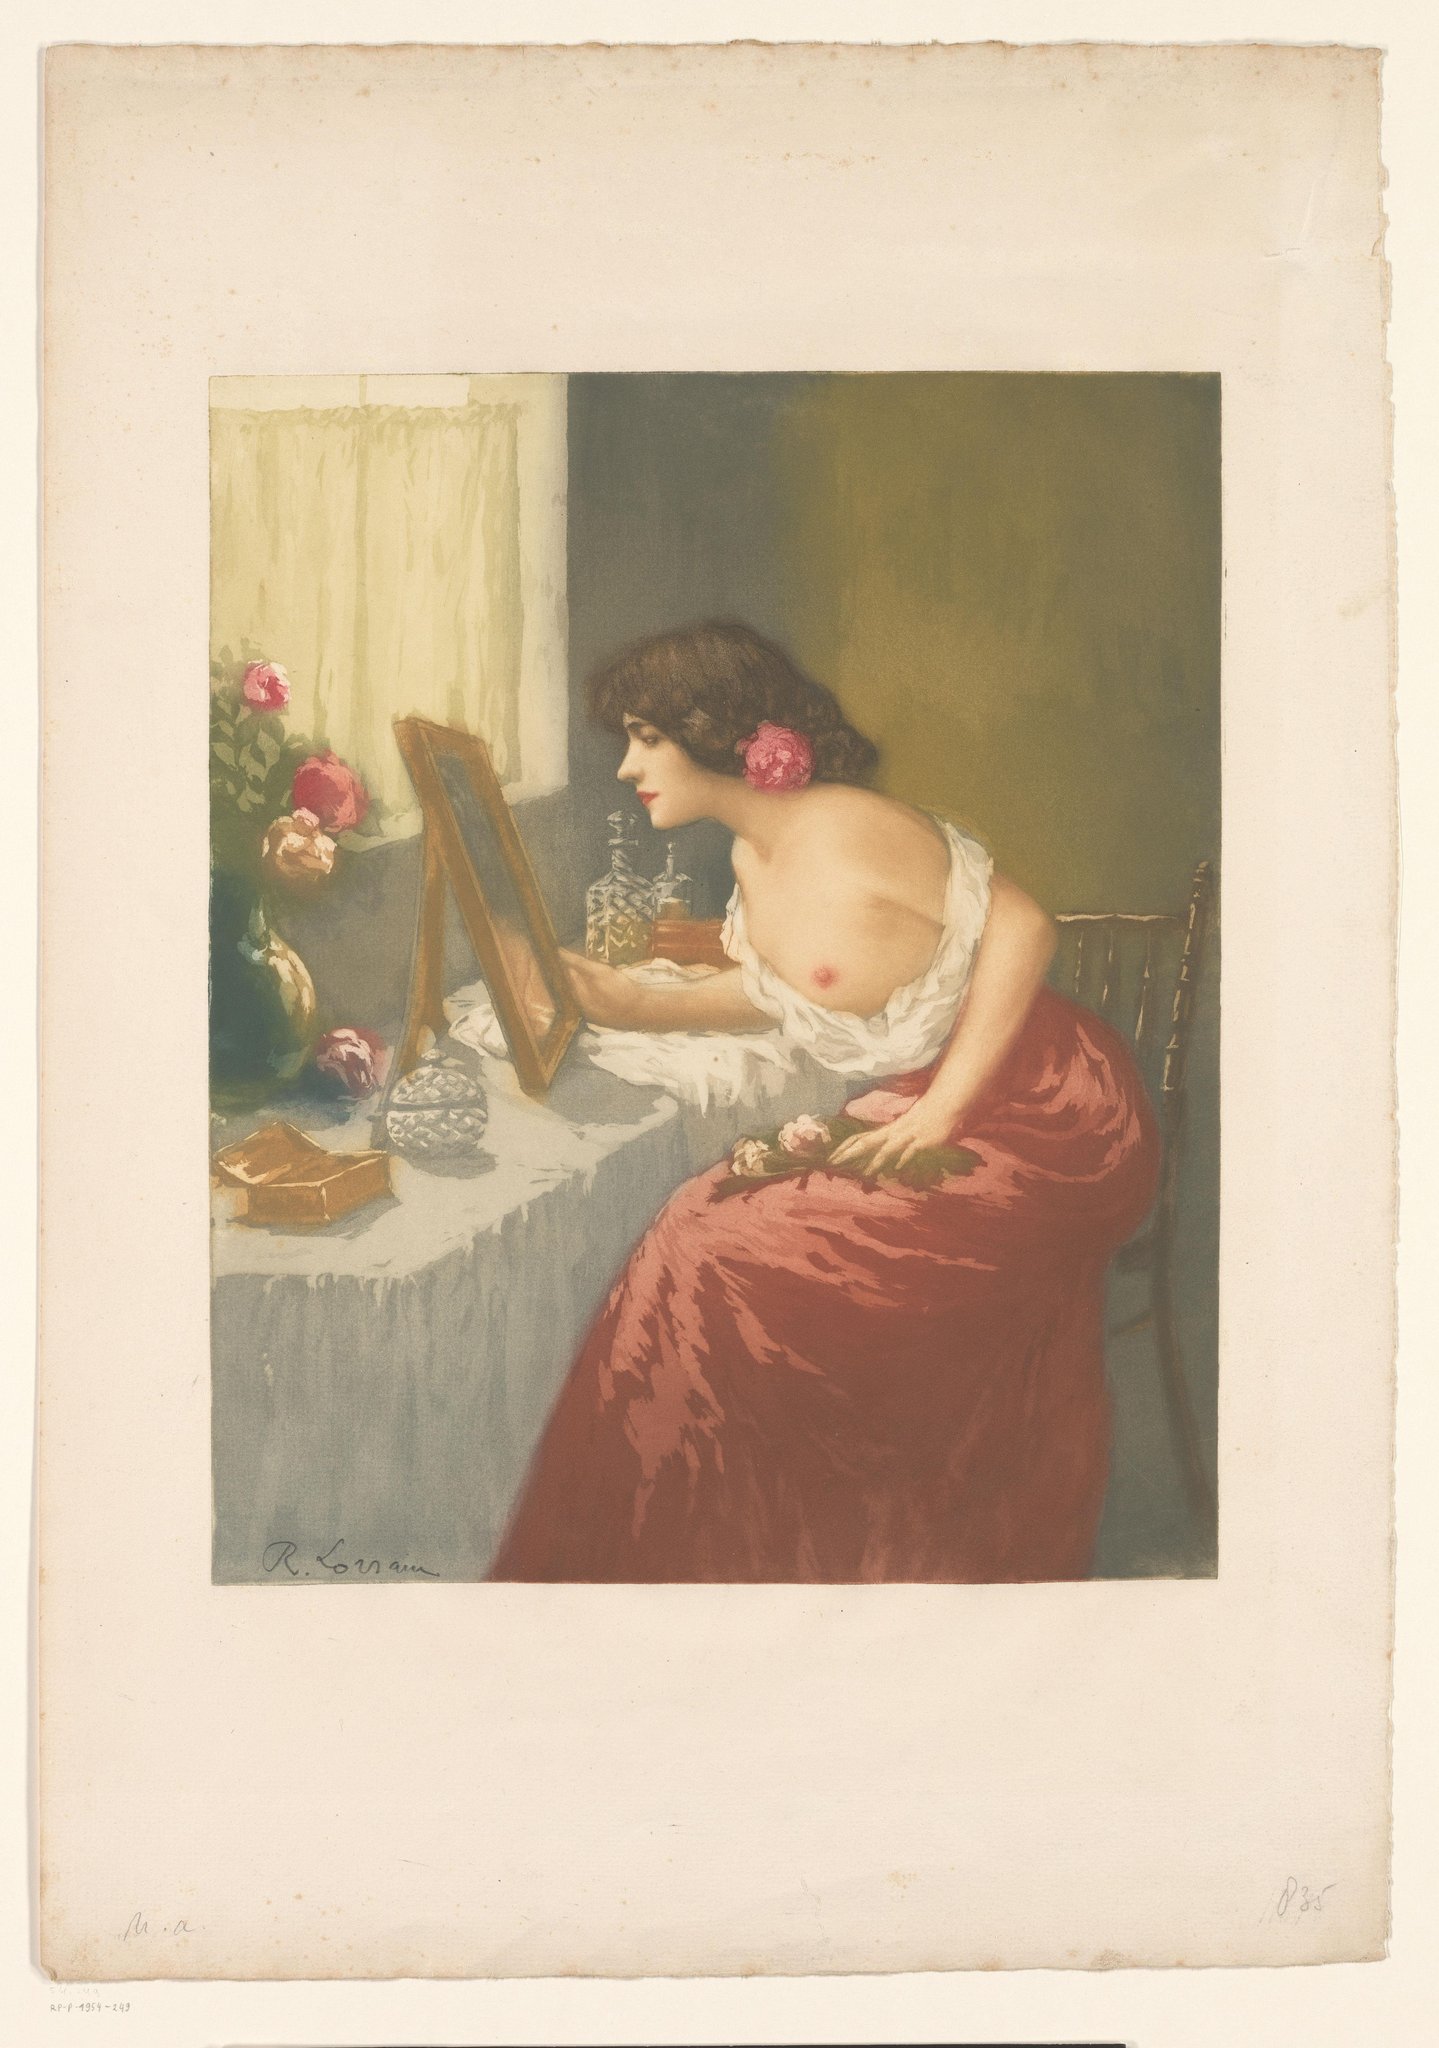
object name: print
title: Vrouw voor een toilettafel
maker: rené lorrain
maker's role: print maker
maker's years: 1873-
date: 1883-1954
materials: paper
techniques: color aquatint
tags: making toilet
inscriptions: collector's mark: Lugt 2228, collector's mark: Lugt 2760